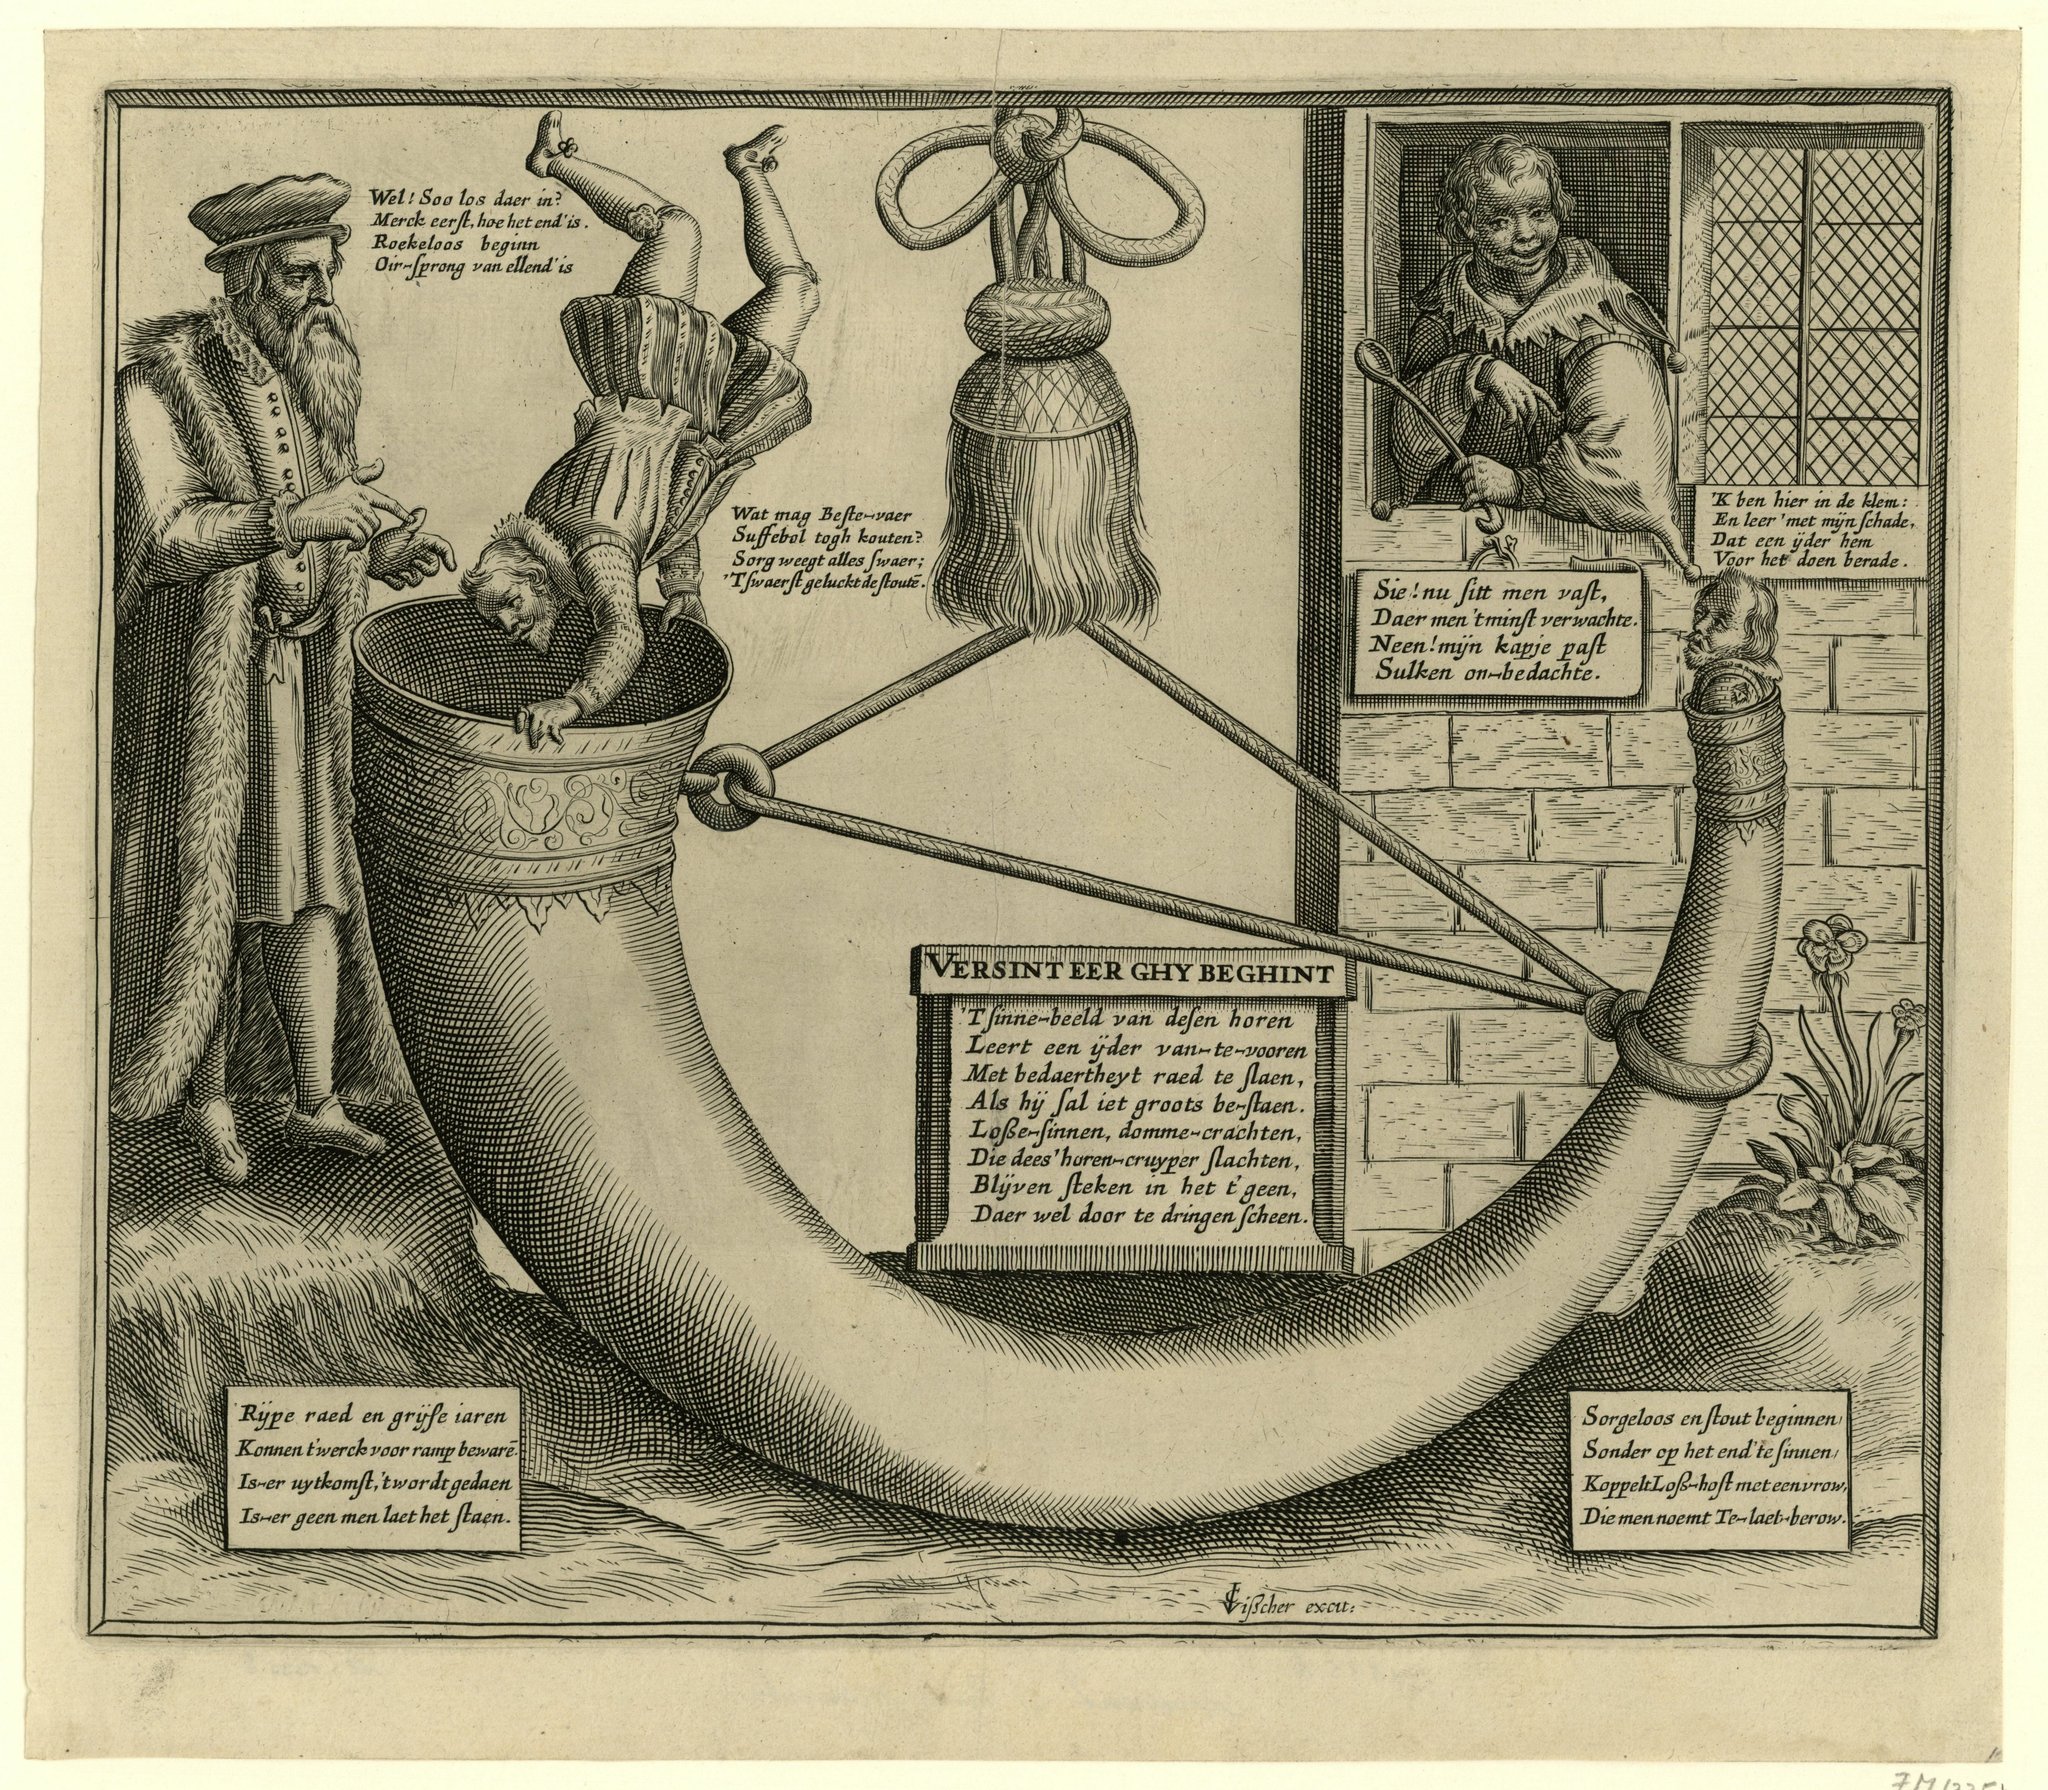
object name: cartoon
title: Spotprent op de arminianen, 1618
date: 1618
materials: paper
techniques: engraving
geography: amsterdam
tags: court jester, court fool, horn, trumpet, cornet, trombone, tuba, proverbs, sayings, etc., drinking-horn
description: Moralistische voorstelling die weleens wordt geïnterpreteerd als een spotprent op de arminianen in 1618. Het opschrift in het midden 'Versint eer ghy beghint' duidt het onderwerp van de voorstelling beter aan. Ondanks de waarschuwingen van een oude man duikt een jongeman in de wijde opening van een grote hoorn. Vervolgens komt hij echter in de smalle uiteinde klem te zitten. Rechts kijkt een lachende nar uit het raam en verwoordt het moraal van de prent, het spreekwoord 'Bezint eer ge begint' of 'Hij werkt zich in het nauw'. Zie ook de interpretatie van de 'hoornkruiper'. Met zeven versjes in de voorstelling.